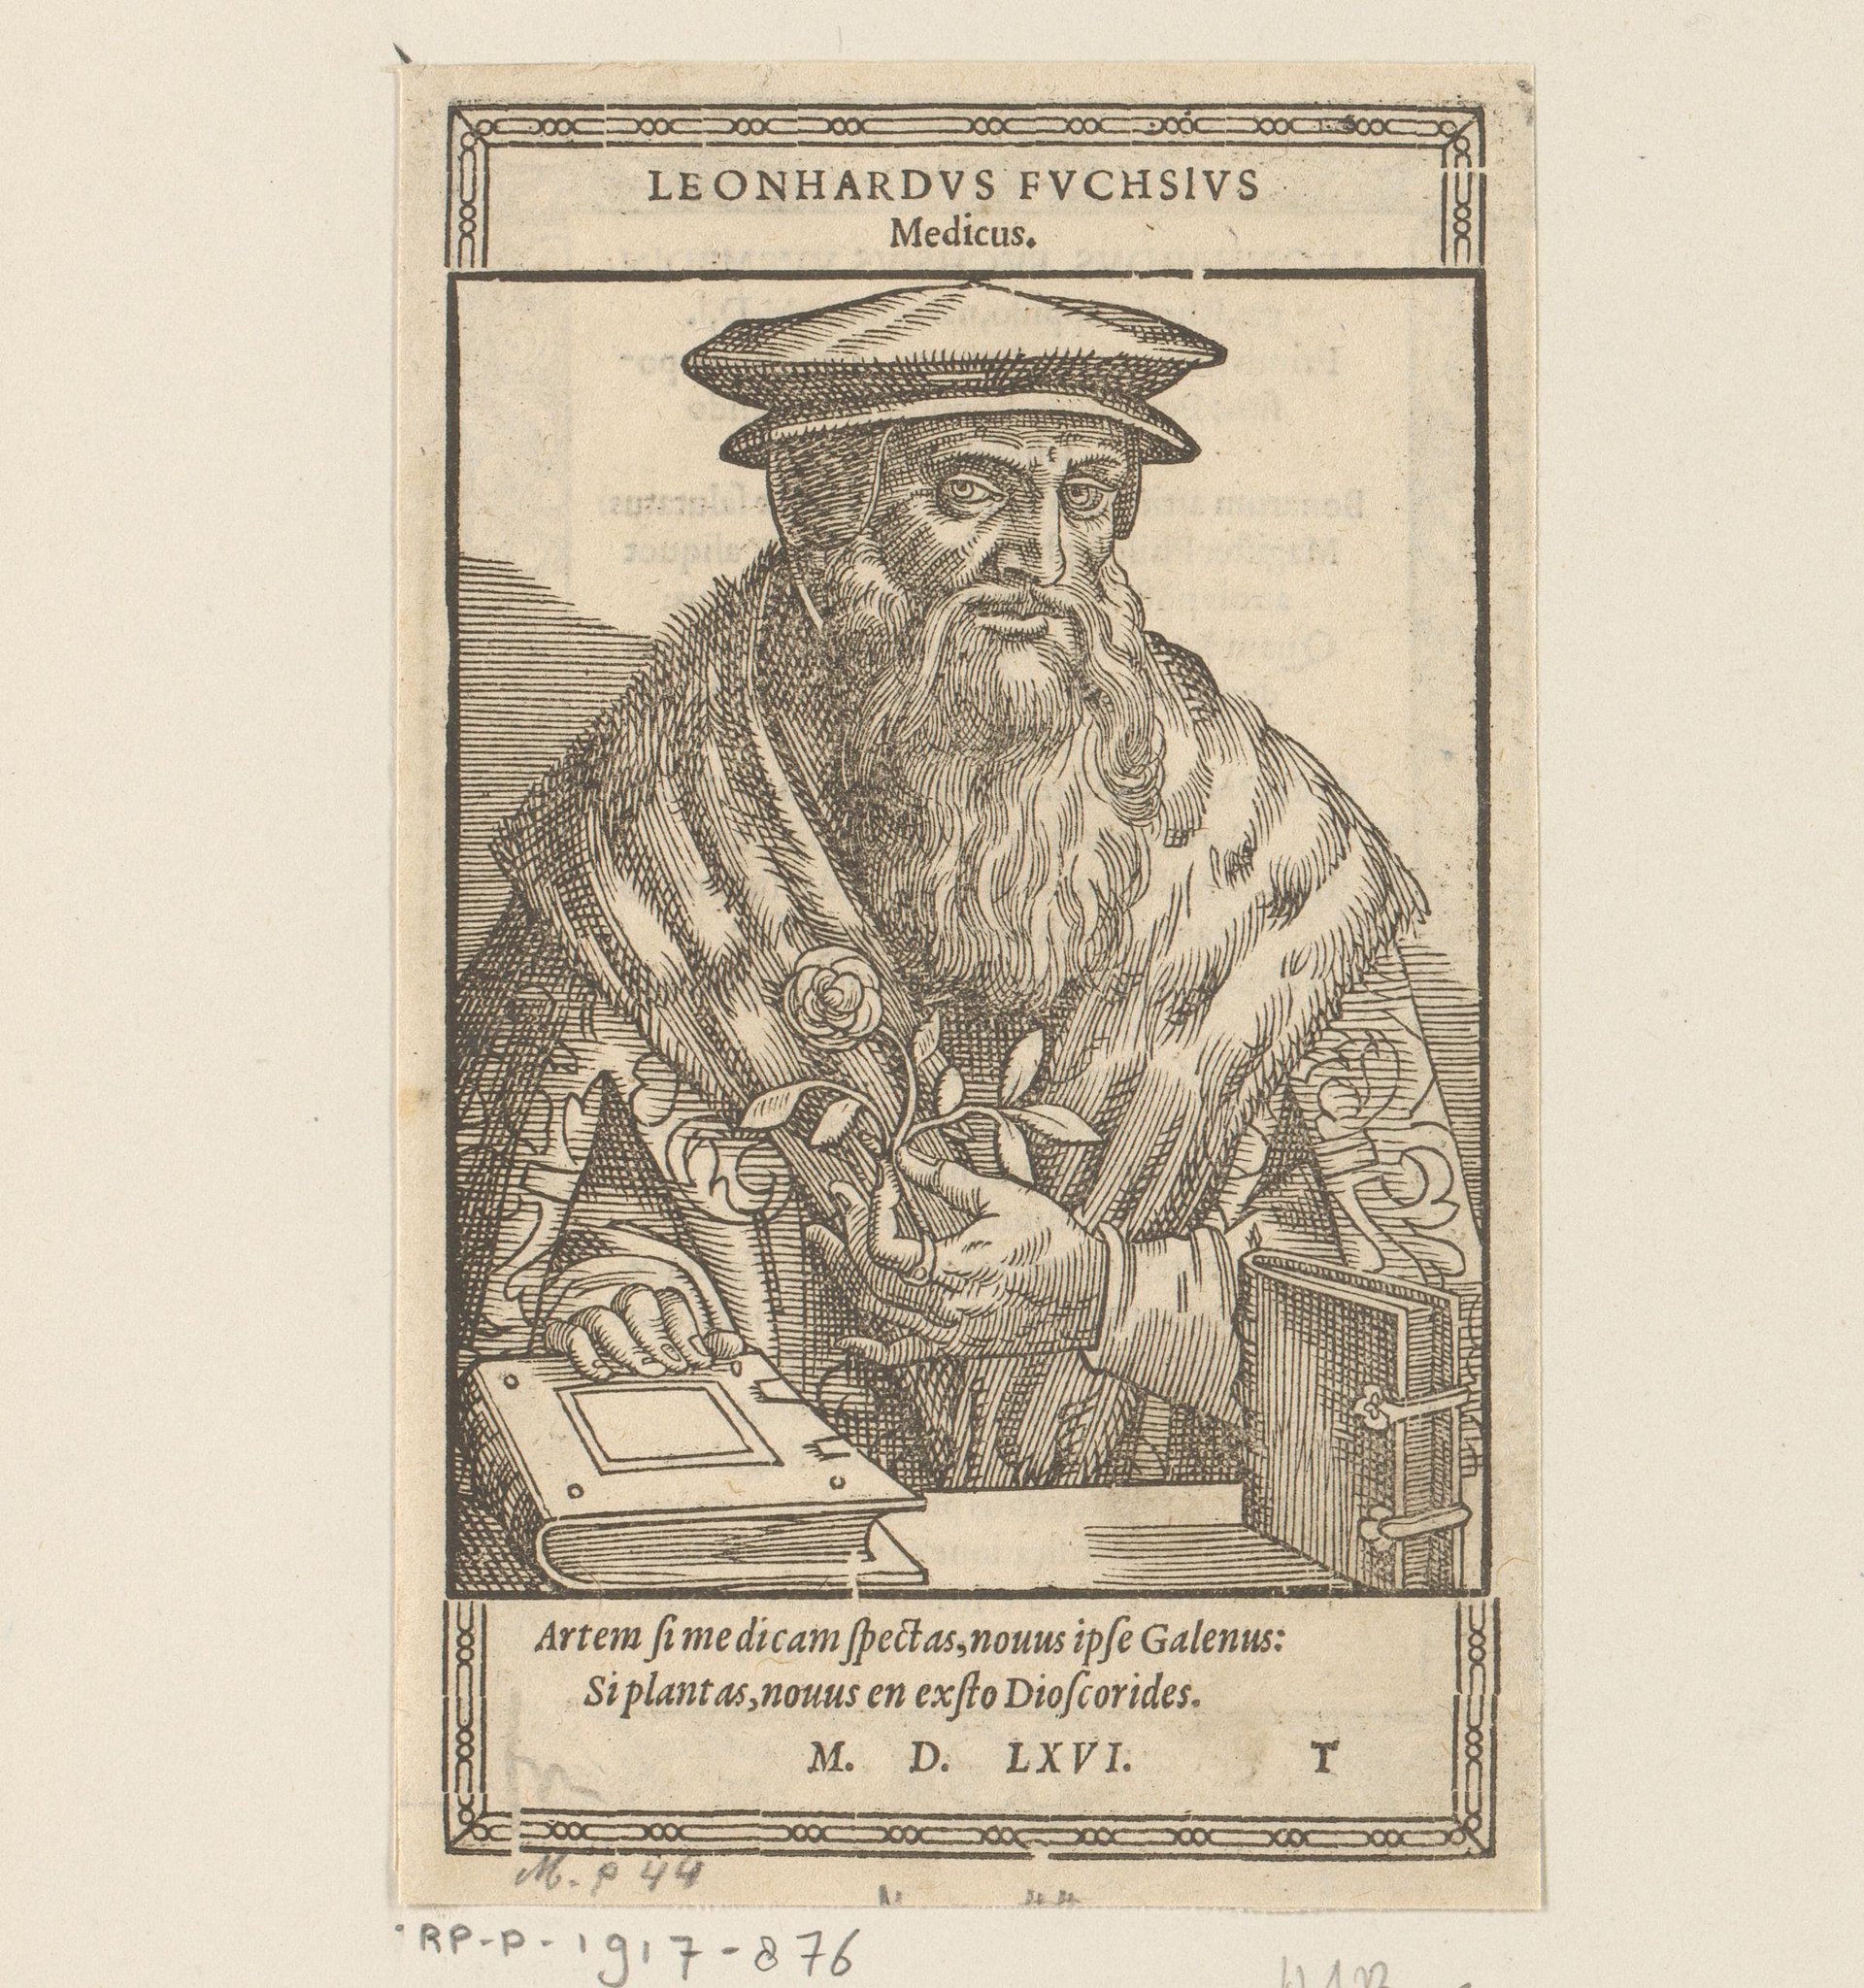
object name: print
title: Portret van Leonhart Fuchs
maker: bernhard jobin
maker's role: printer, publisher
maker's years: 1545-1593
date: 1587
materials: paper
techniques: letterpress printing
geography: straatsburg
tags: historical persons, physician, doctor, book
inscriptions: collector's mark: Lugt 2228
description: Prent uit: Reusner, Nikolaus. Icones sive imagines virorum literis illustrium (...). Straatsburg: Bernhard Jobin, 1587. Prent ook gebruikt in de Duitse editie, uitgegeven in hetzelfde jaar, en de 1590-editie. Prent ook gebruikt in latere publicaties.